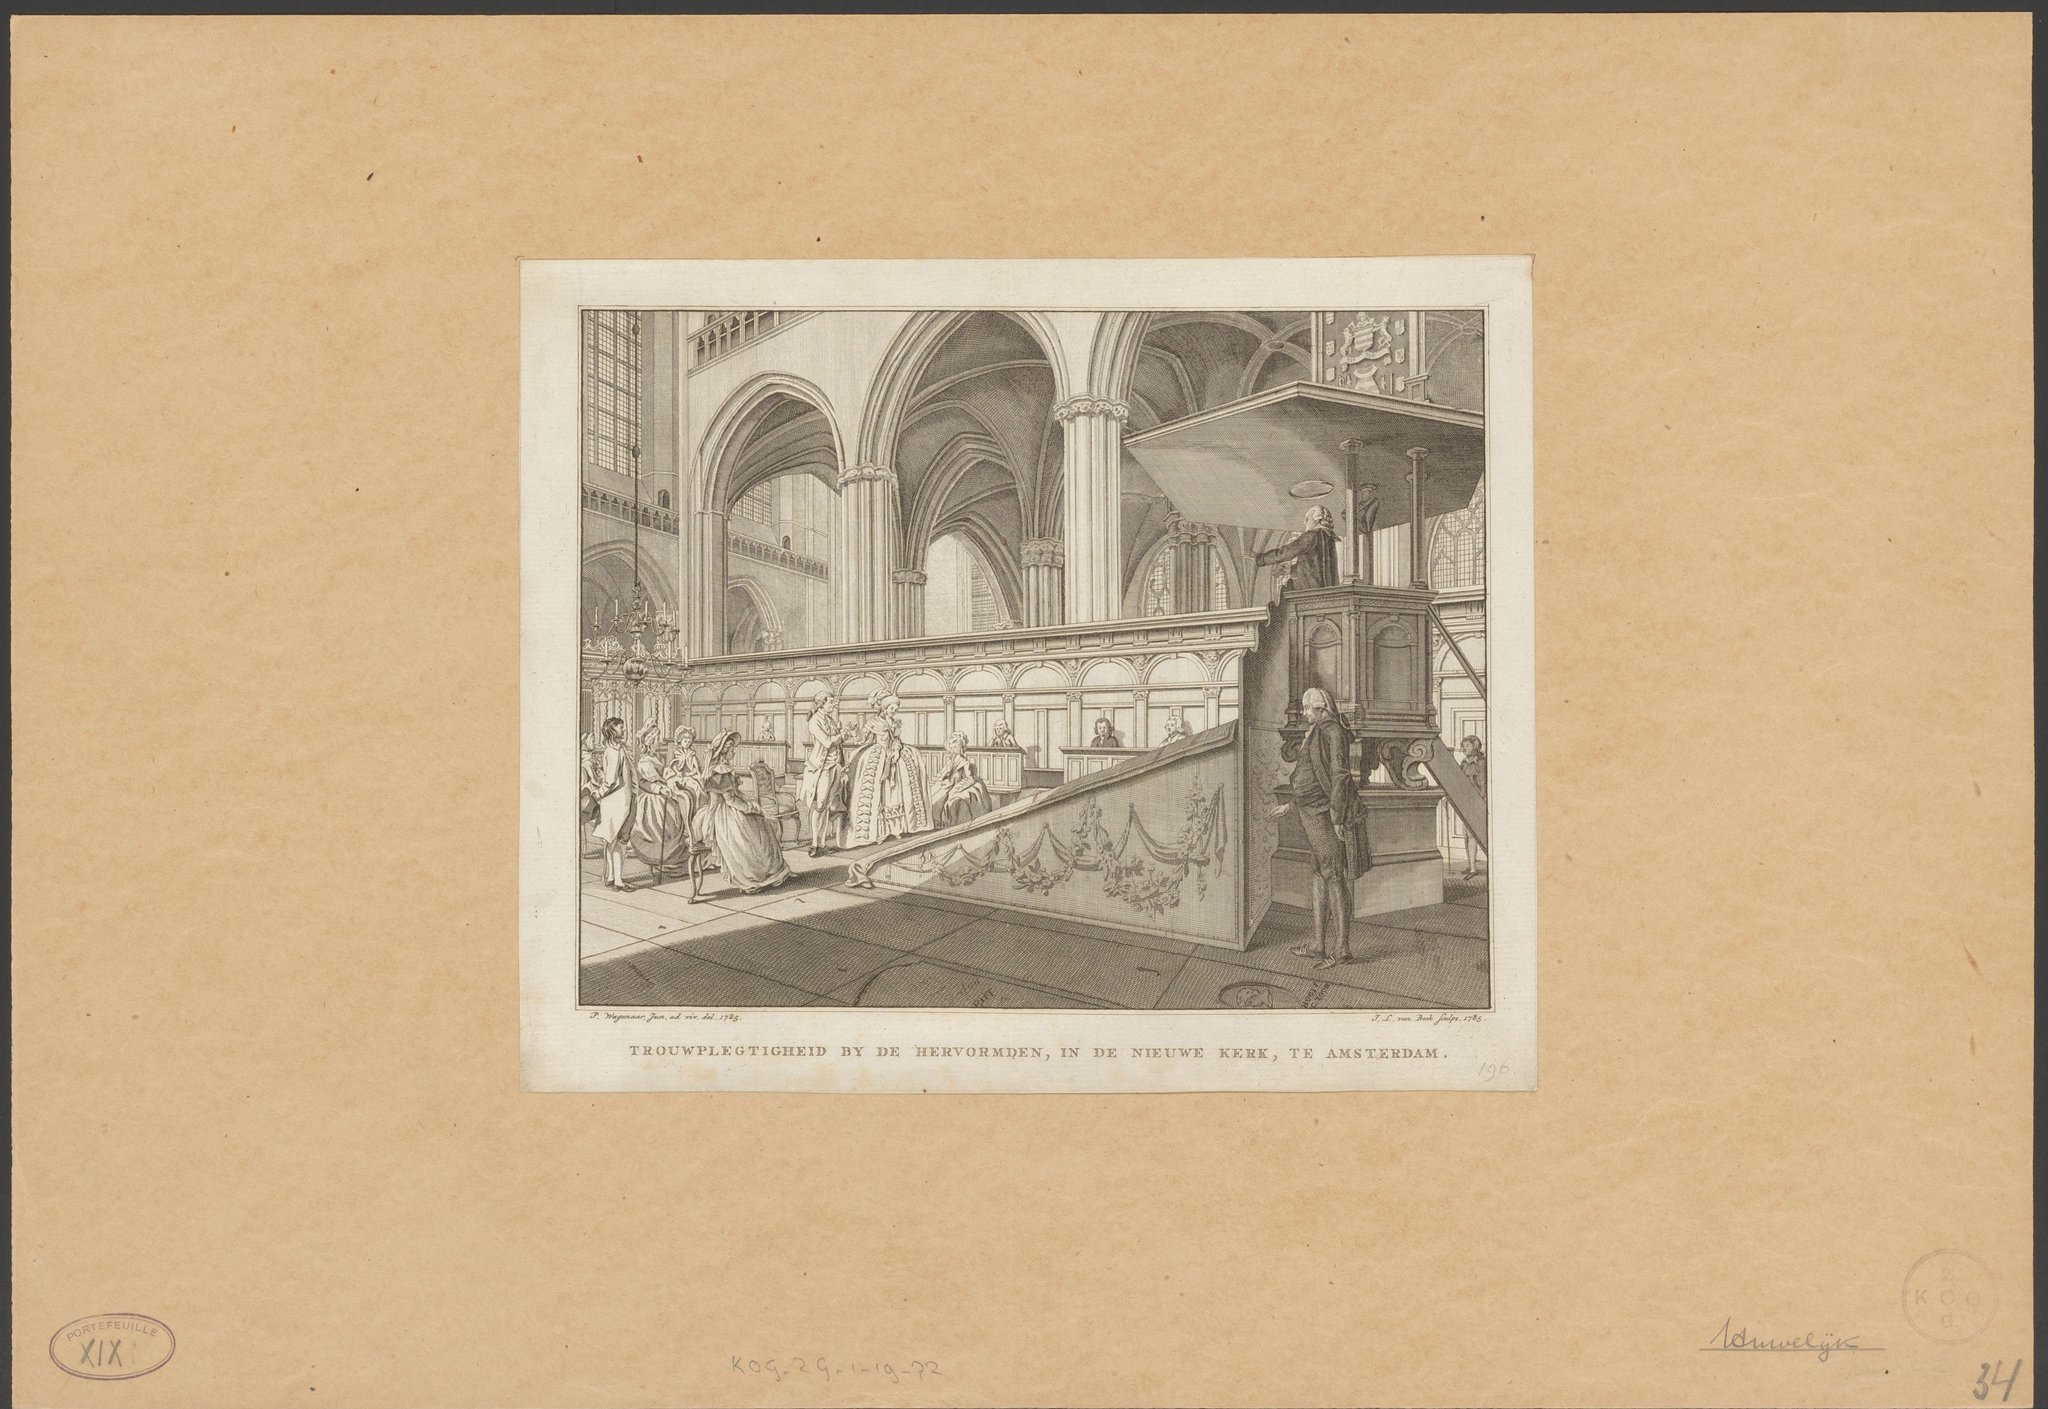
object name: print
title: Trouwplegtigheid by de hervormden, in de Nieuwe Kerk, te Amsterdam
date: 1785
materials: paper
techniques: engraving, etching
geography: amsterdam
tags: interior of church, (civil) marriage ceremonies, marriage ~ protestant service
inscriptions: collector's mark, collector's mark: Lugt 1641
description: Hervormde huwelijksceremonie in de Nieuwe Kerk te Amsterdam. Onderwerpsrubrieken binnen de Atlas Zeden en Gewoonten: Des Menschen Begin, Midden en Einde. Bruiloft en huwelijk.